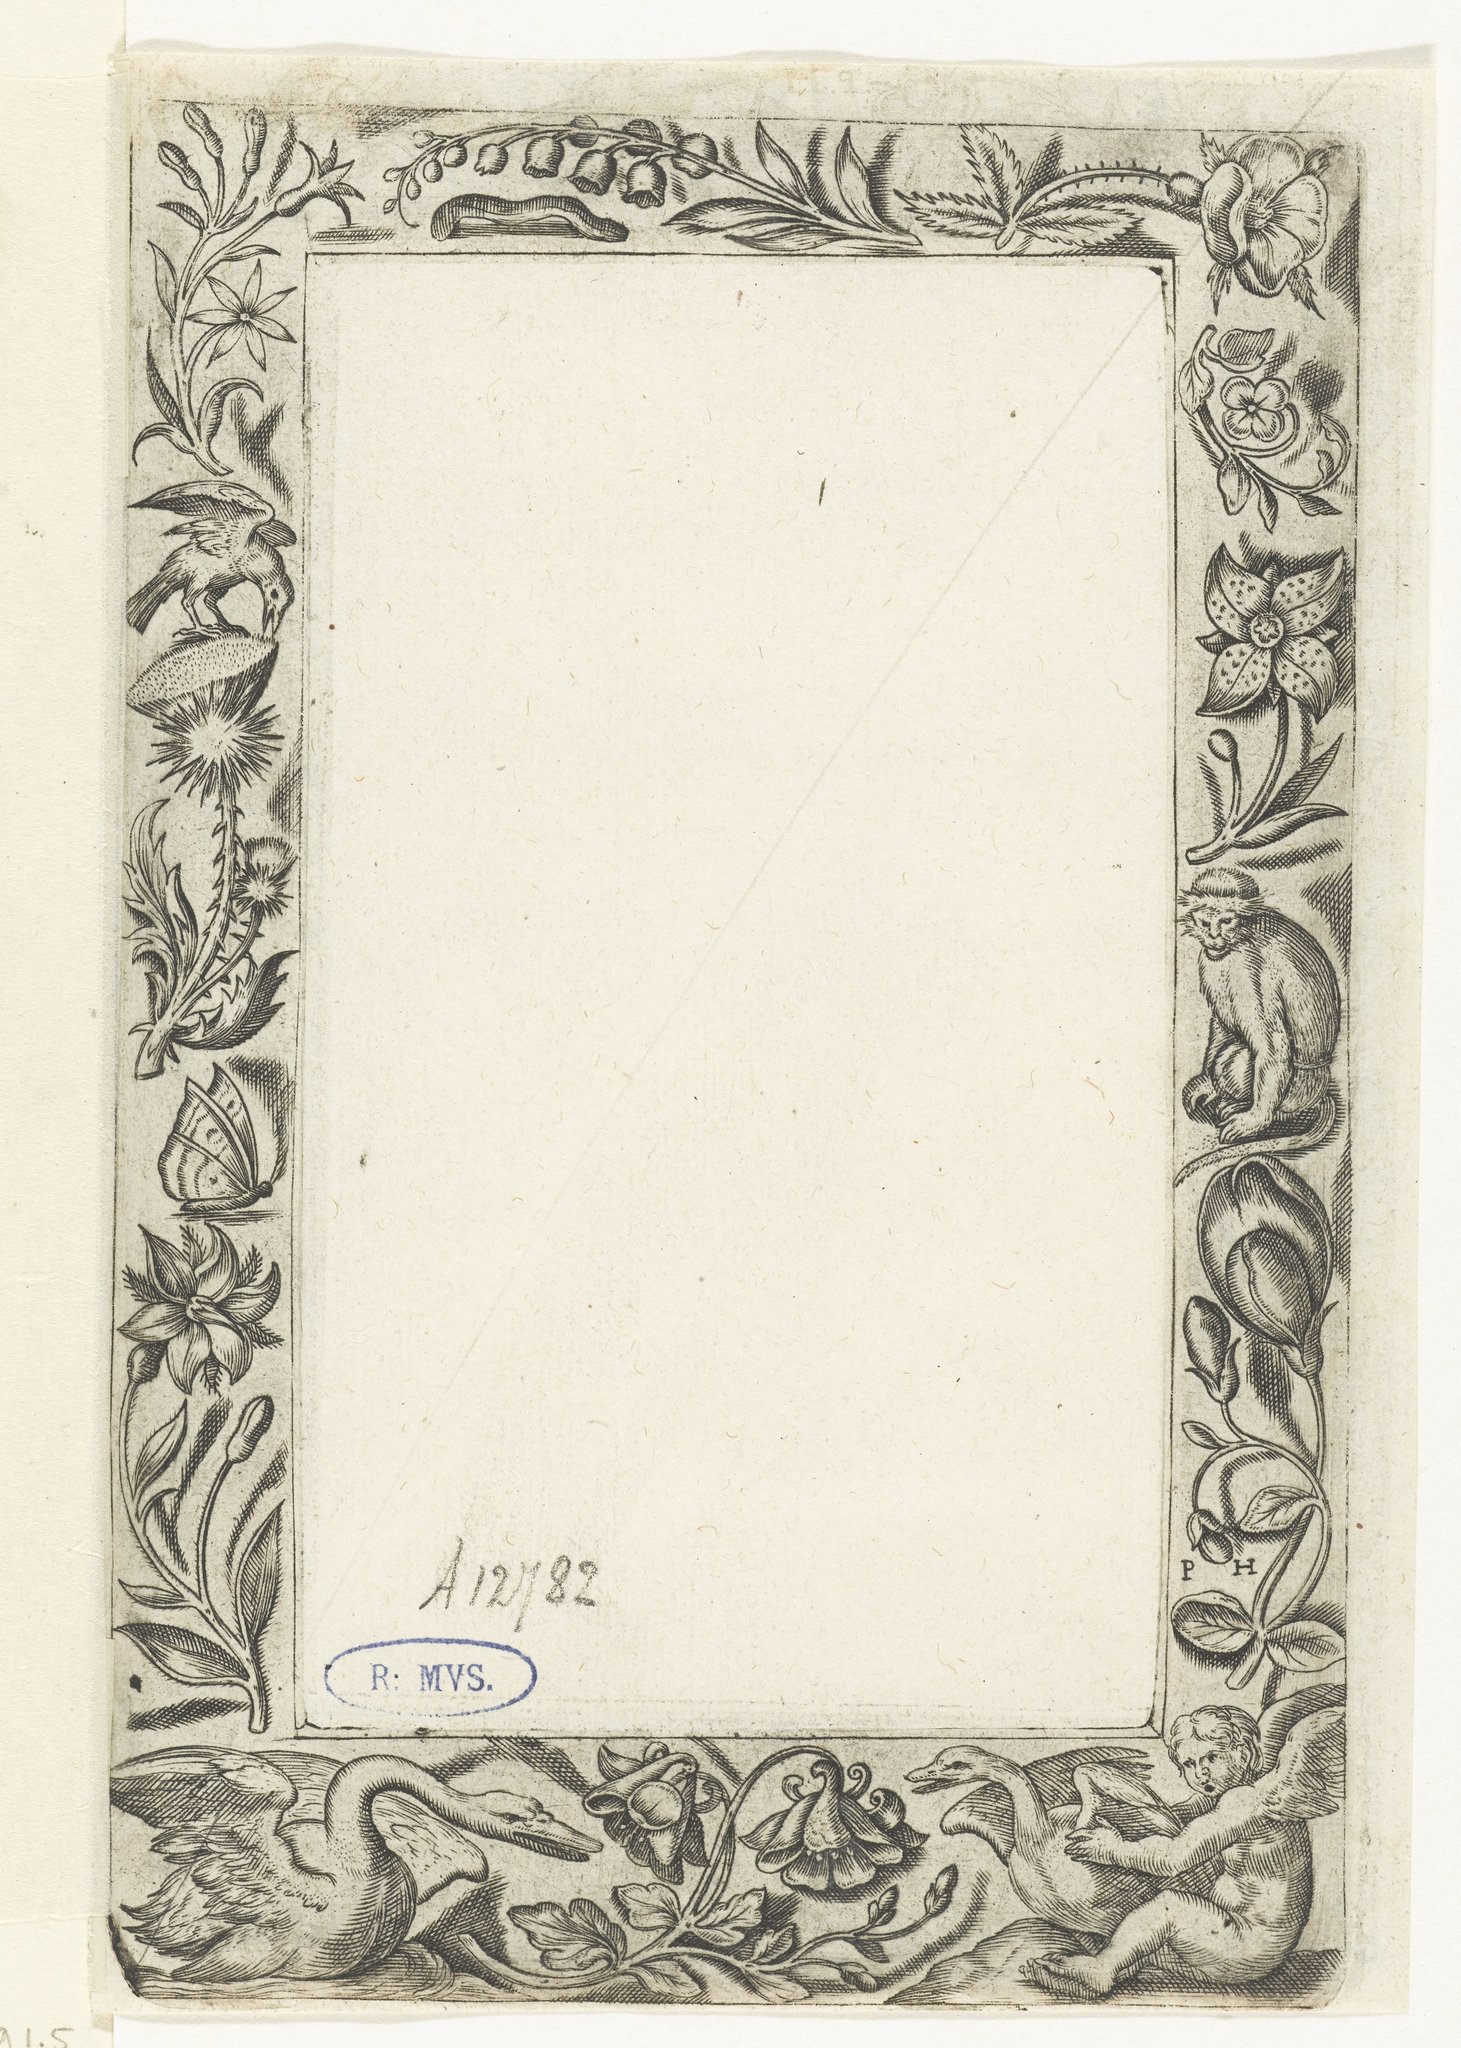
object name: ornament print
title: Omlijsting met middenonder een akelei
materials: paper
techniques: etching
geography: netherlands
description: De akelei bevindt zich tussen een zwaan (links) en een engeltje met een zwaan (rechts). In de rechter rand zit een aapje. Eén van 6 bladen, aan weerszijden bedrukt, met acht verschillende omlijstingen rondom een niet bedrukt middenveld.